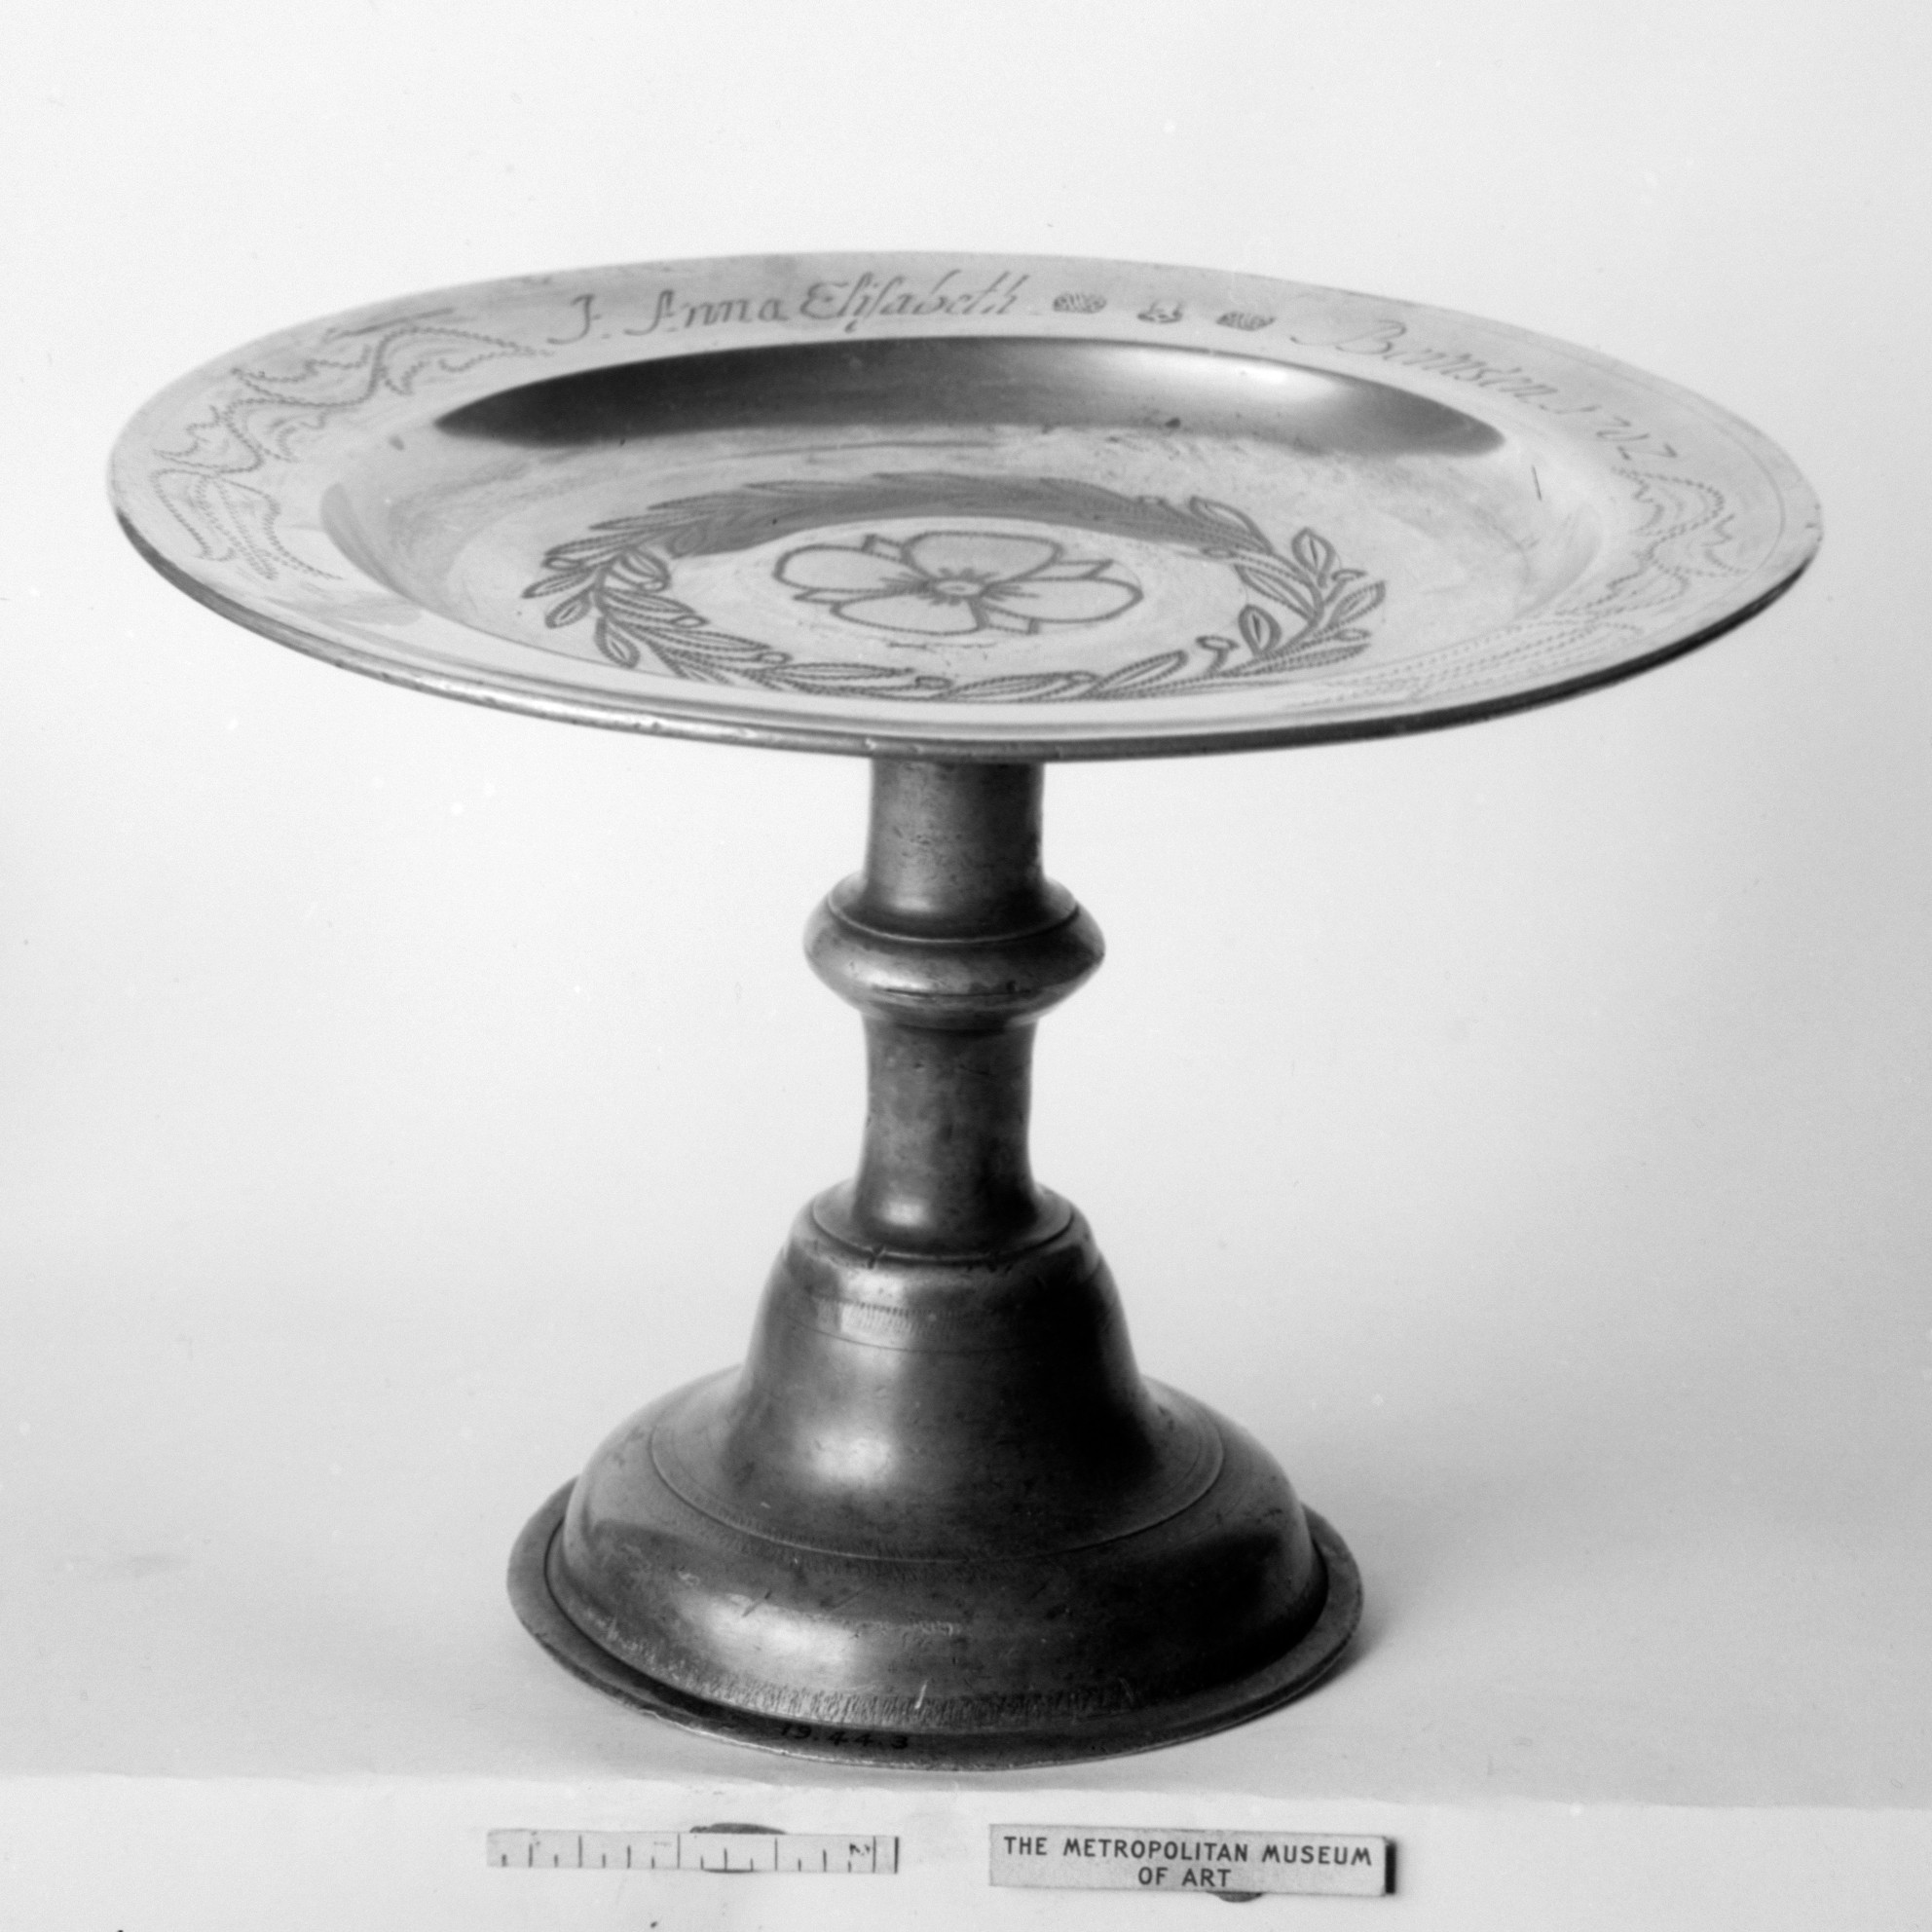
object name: compote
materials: pewter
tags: flowers